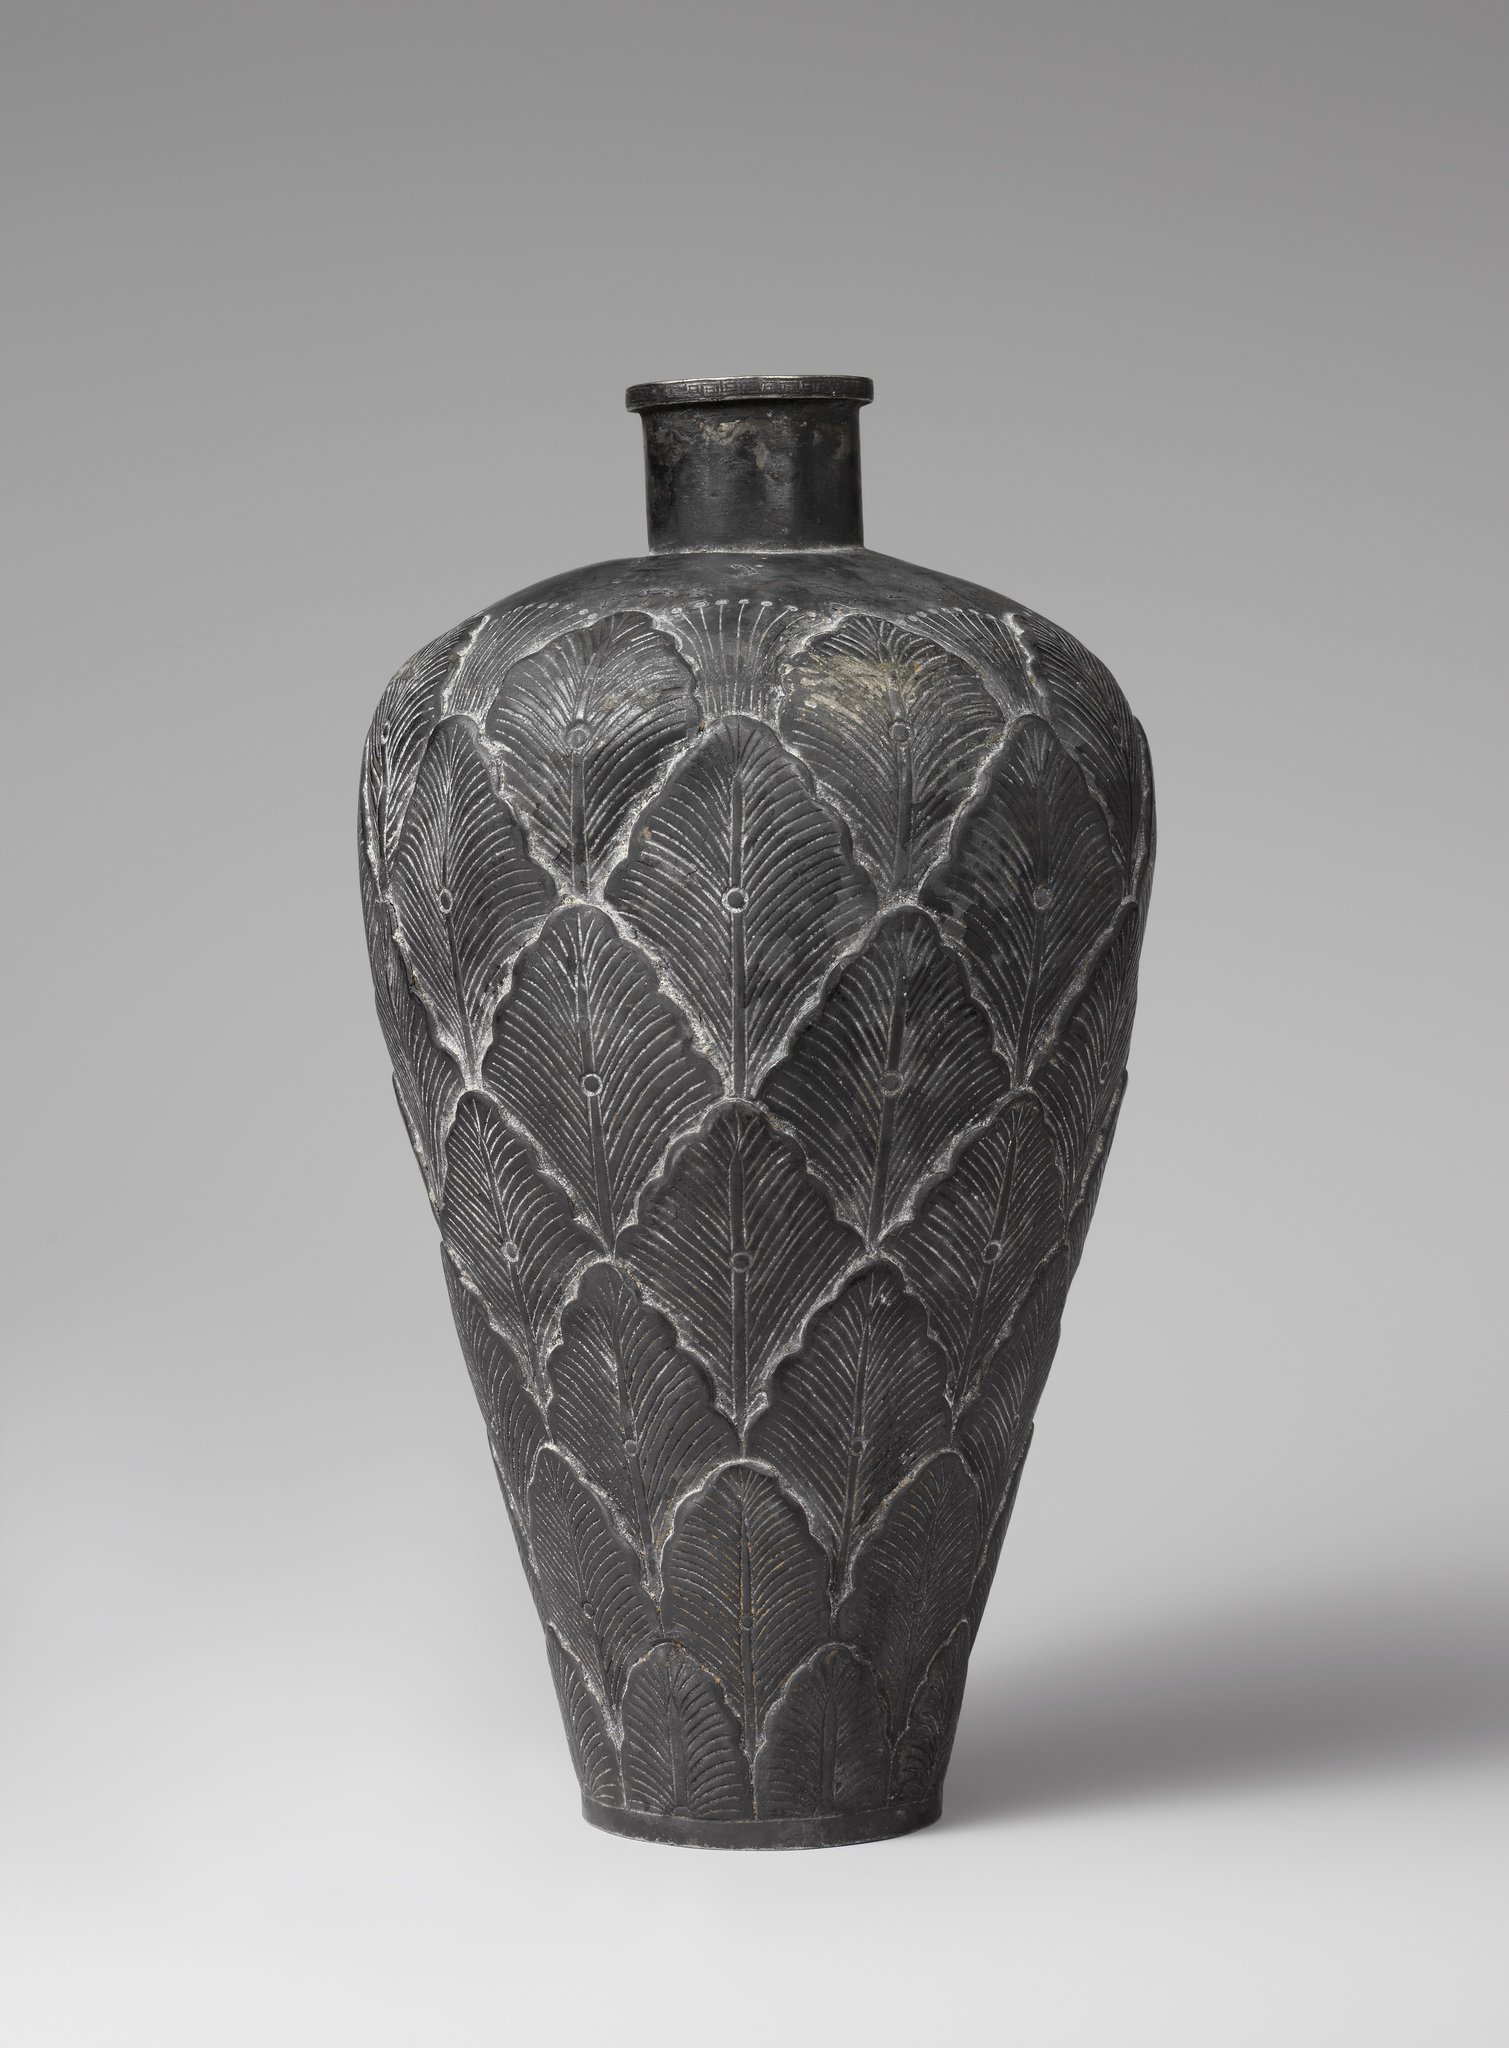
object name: bottle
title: Bottle with Overlapping Petals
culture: chinese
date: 1001-1133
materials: silver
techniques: chasing, incising, repoussé